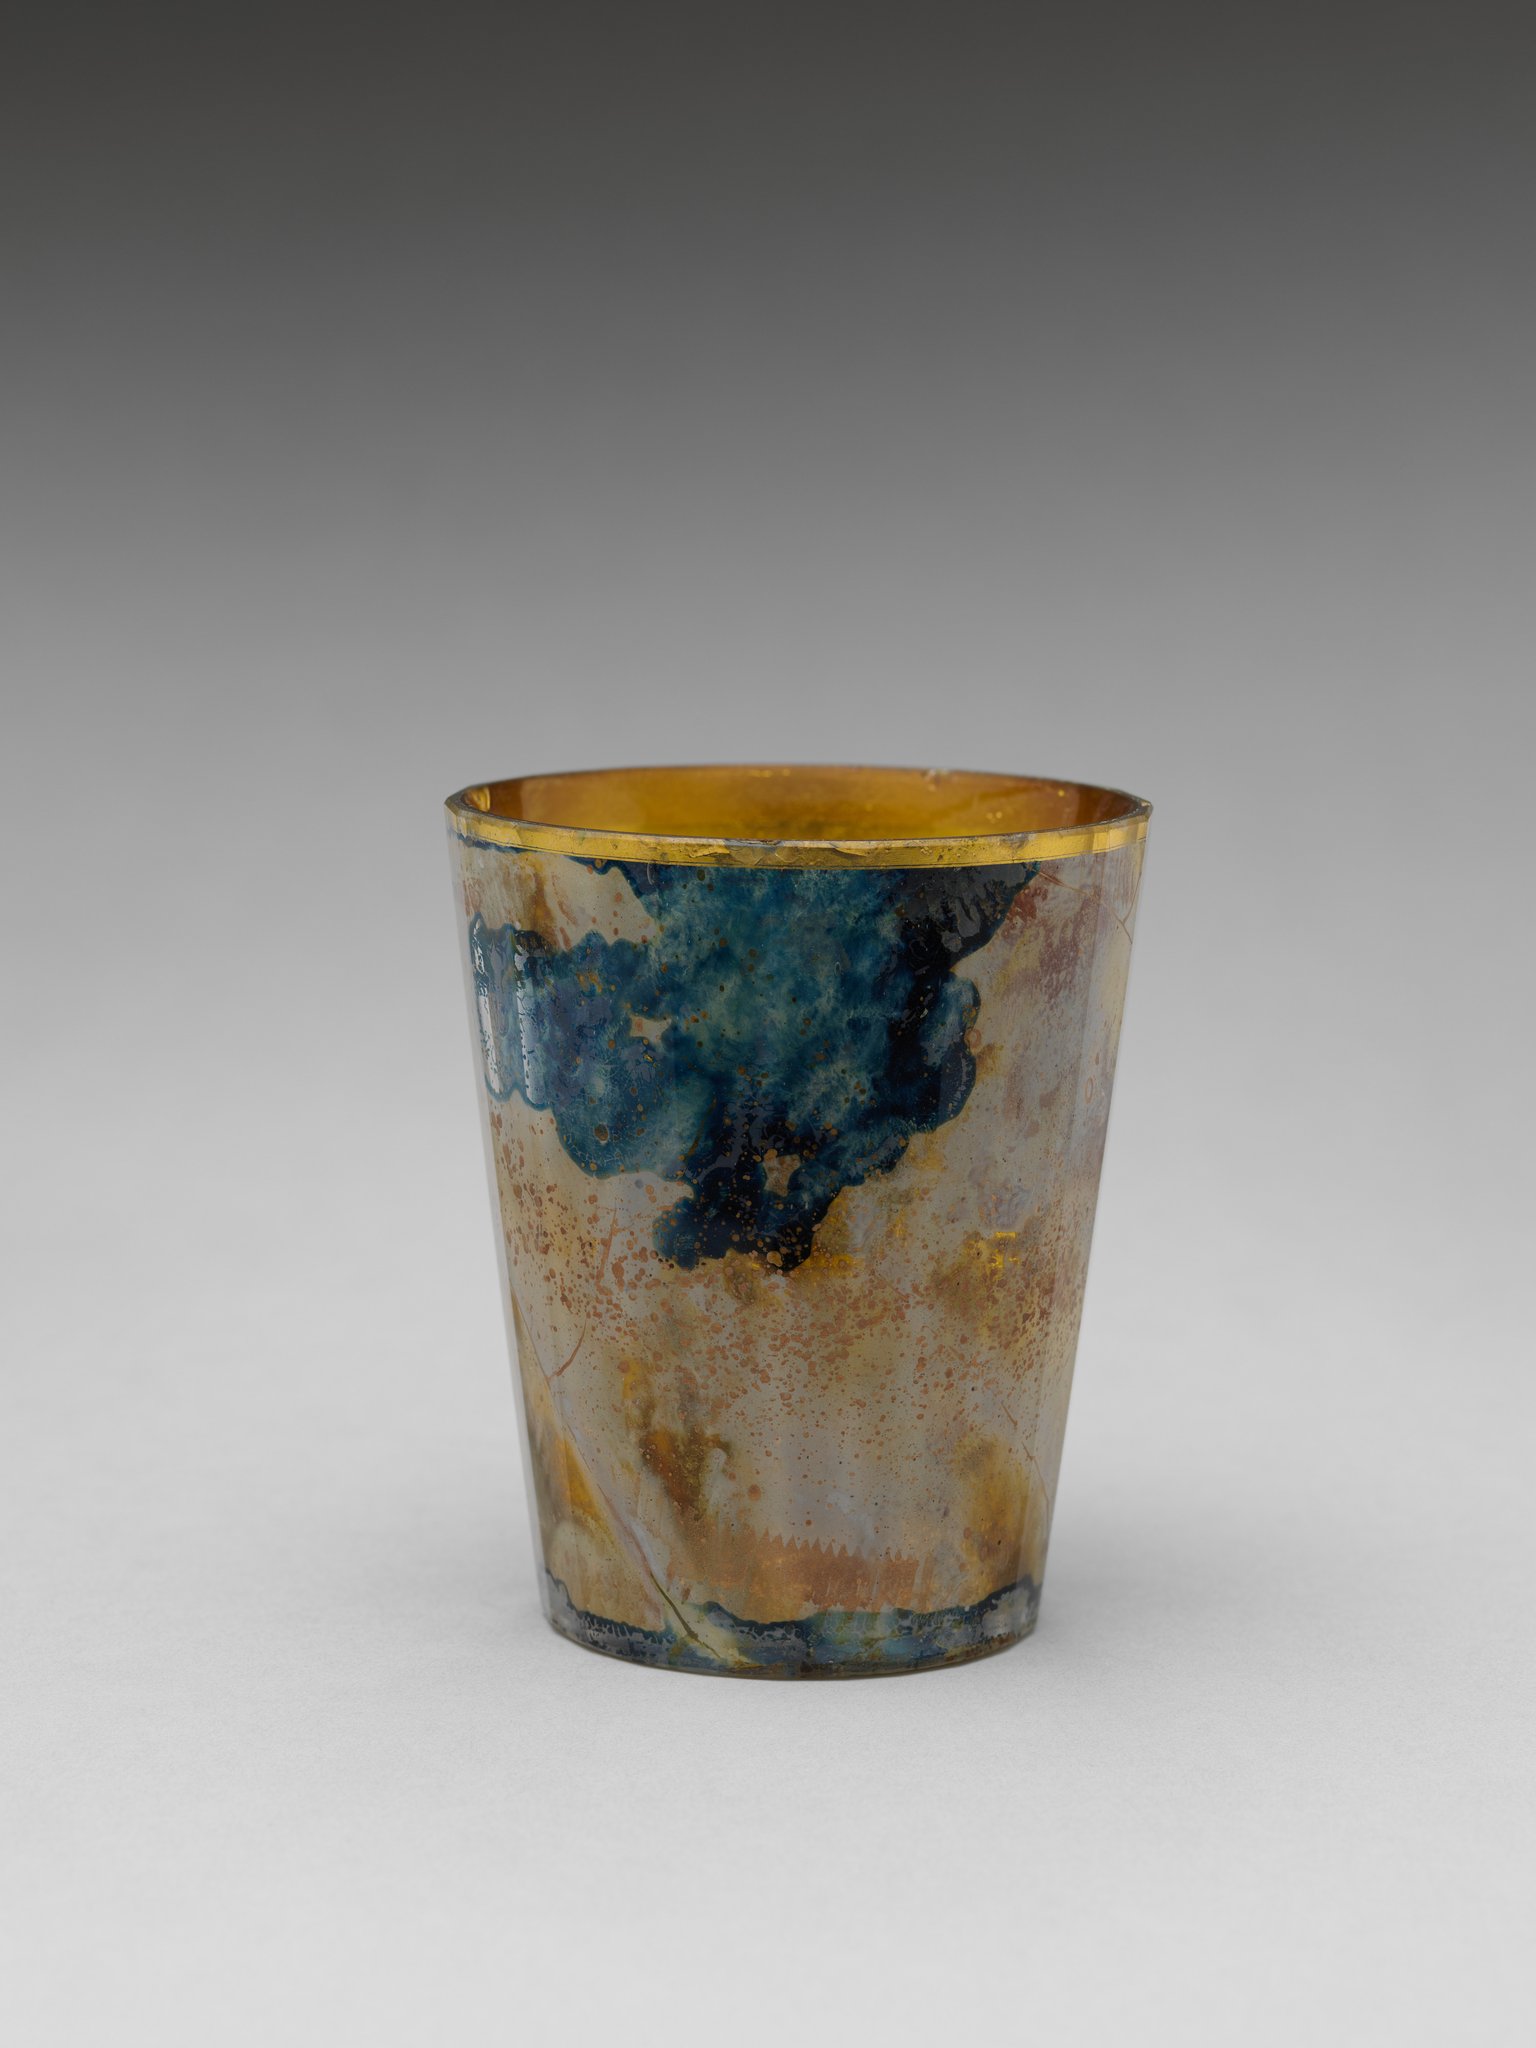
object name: beaker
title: Cream and blue marbled beaker in "zwischengold" glass technique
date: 1701-1733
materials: gilt, glass, marble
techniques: lacquer, polish